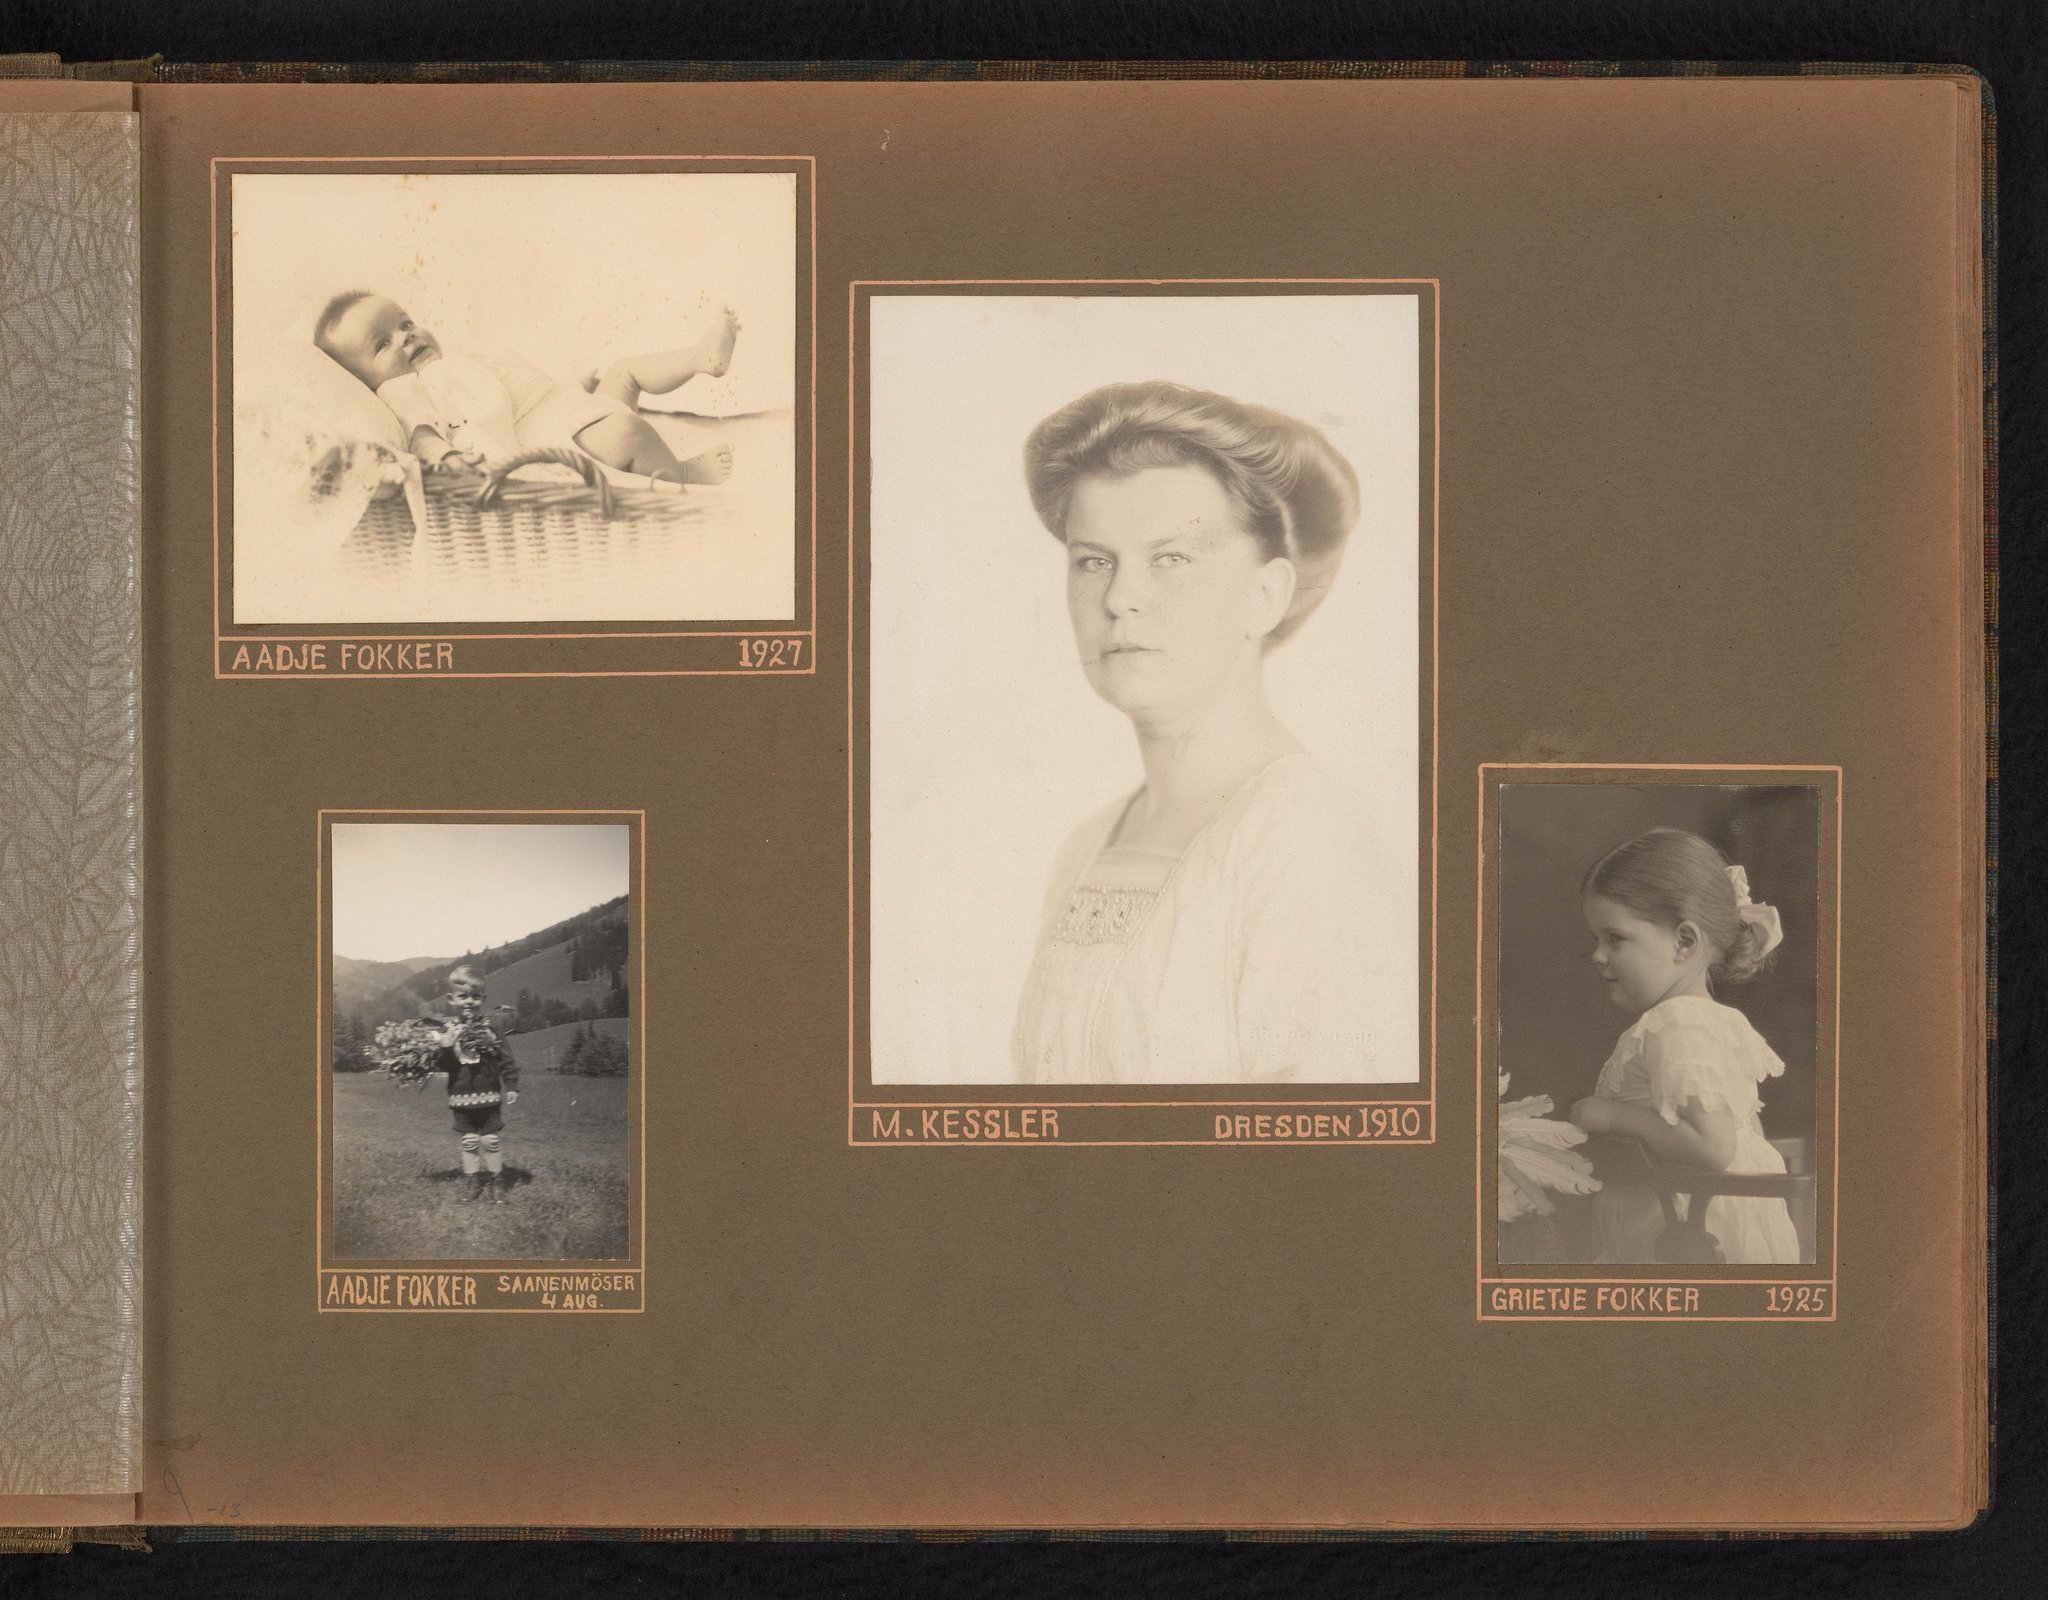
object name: album leaf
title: Go Fokker-Kessler met haar twee kinderen, Adriaan en Griet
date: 1912-1930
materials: paper, cardboard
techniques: gelatin silver print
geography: dresden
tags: mother and child(ren), woman and child(ren) (family group)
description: Deze foto's zijn onderdeel van een album.